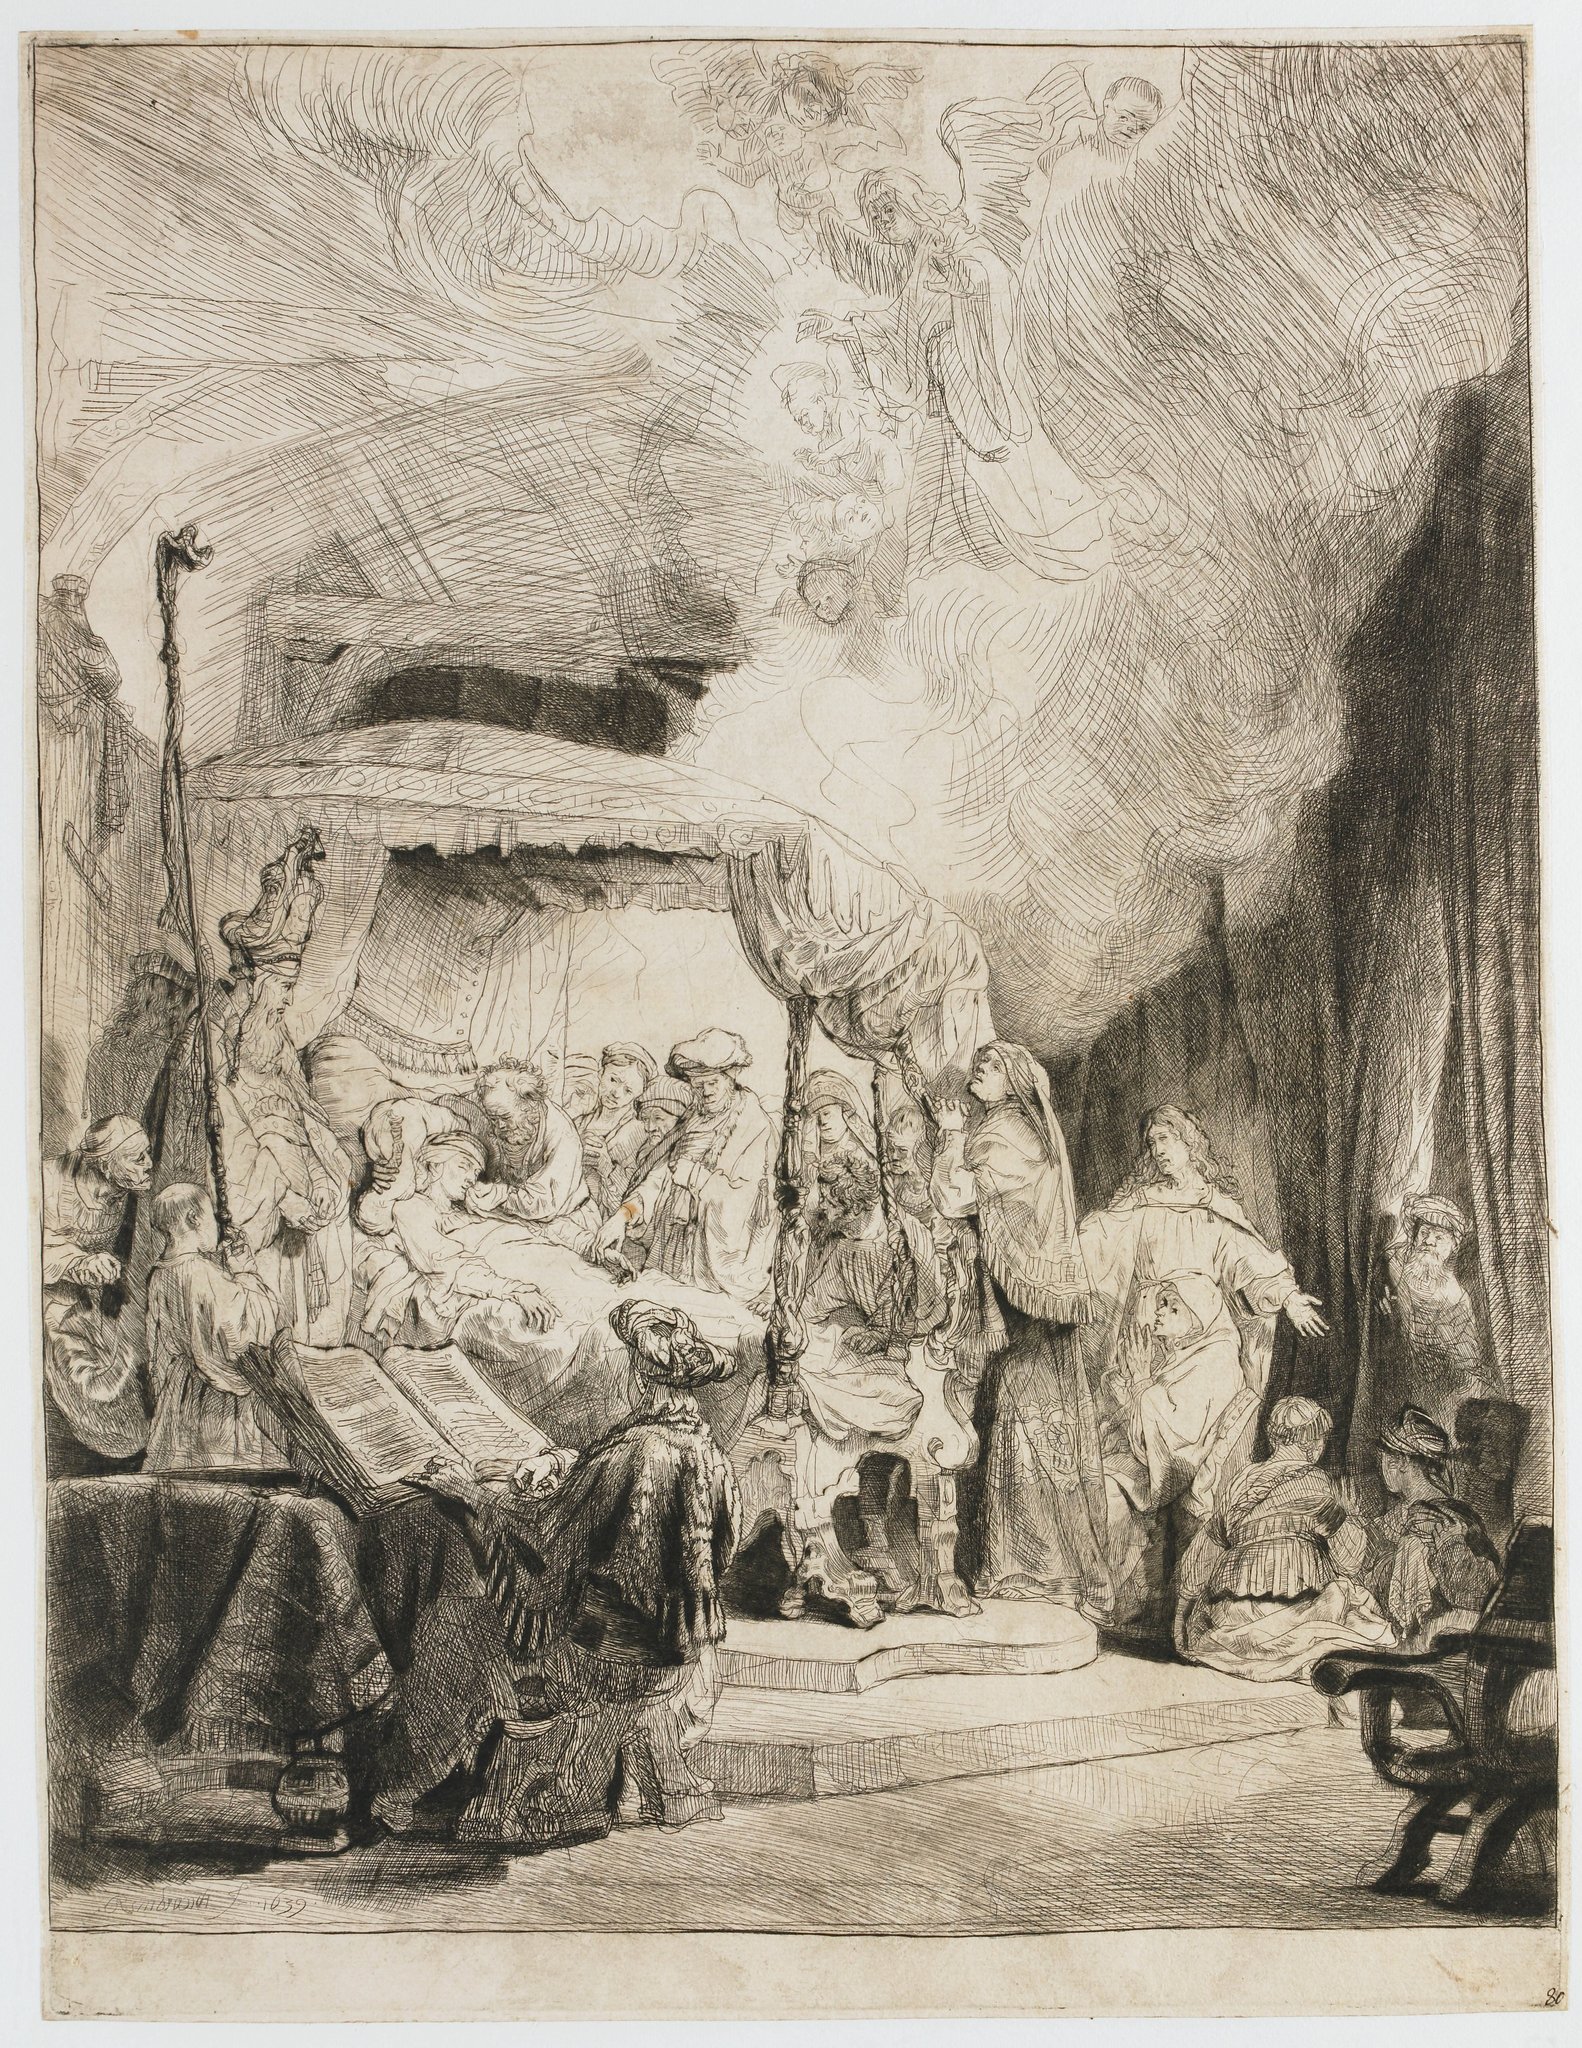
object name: print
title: The death of the Virgin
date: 1639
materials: paper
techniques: drypoint, etching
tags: the dormition: mary on her deathbed; the apostles are gathered around her (john the evangelist may be shown sleeping or dreaming)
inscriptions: signature and date: ‘Rembrandt f 1639’, inscription: ‘80’, collector's mark: Lugt 240